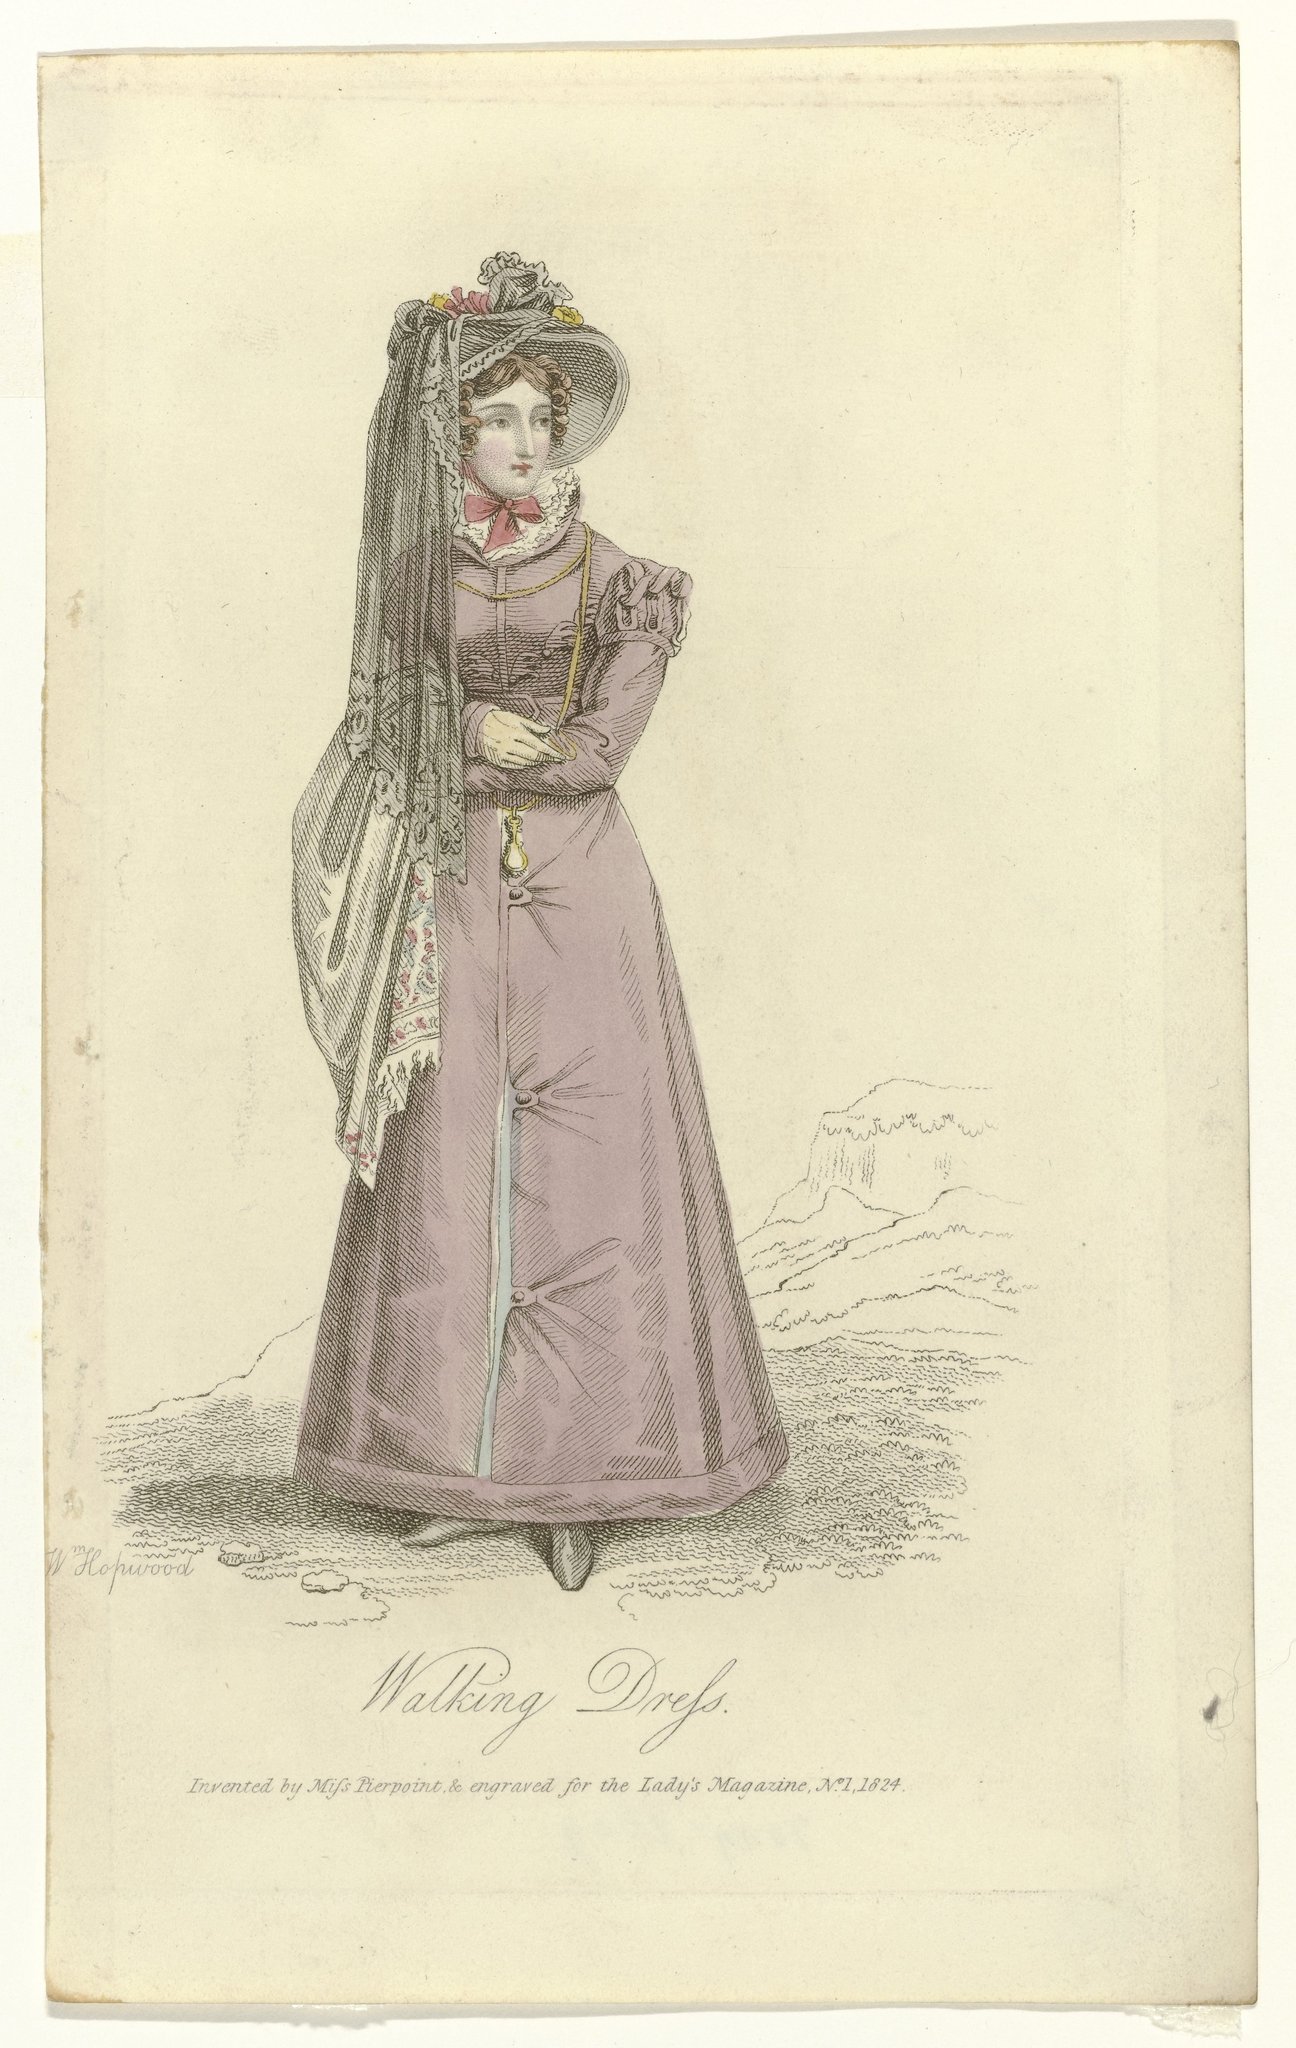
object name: fashion print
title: The Lady's Magazine, 1824, No. 1 : Walking Dress (...)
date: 1824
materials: paper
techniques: engraving, hand coloring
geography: london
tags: clothing for the upper part of the body (shawl) (+ women's clothes), veil (+ women's clothes), dress, gown: walking dress (+ women's clothes), monocle, single lorgnette (+ female (human being) (not to be used where -aa- is prescribed)), head-gear (+ women's clothes), fashion plates, shoes, sandals (+ women's clothes), gloves, mittens, etc. (+ women's clothes), neck-gear ~ clothing (+ women's clothes)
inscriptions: title: ‘Walking Dress.’, caption: ‘Invented by Miss Pierpoint. & engraved for the Lady's Magazine, No. 1, 1824.’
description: Vrouw in een wandeljapon met lange mouwen. Geplooide kraag. Accessoires: luifelhoed met sluier, om de hals een koord met lorgnet, handschoen, sjaal, schoenen. Prent uit het modetijdschrift The Lady's Magazine (1770-1837).